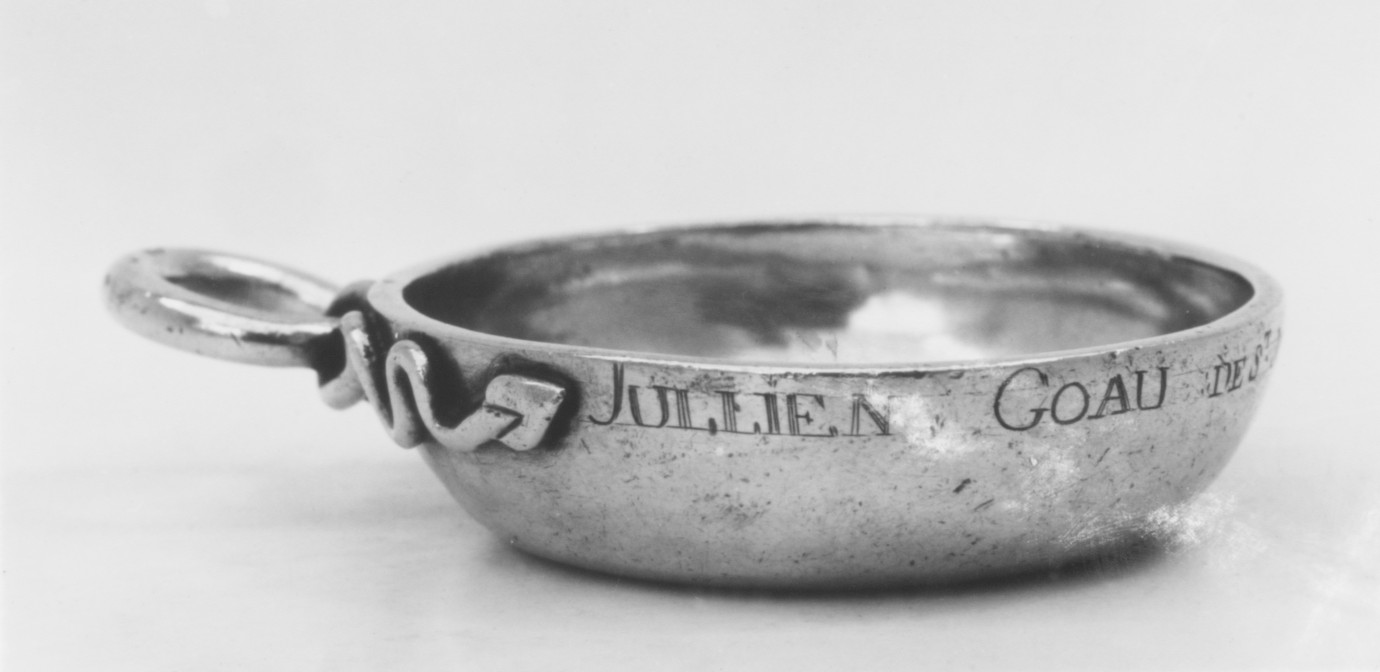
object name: wine taster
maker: pierre ix hanappier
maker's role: maker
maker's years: 1700-1805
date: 1768-1770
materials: silver